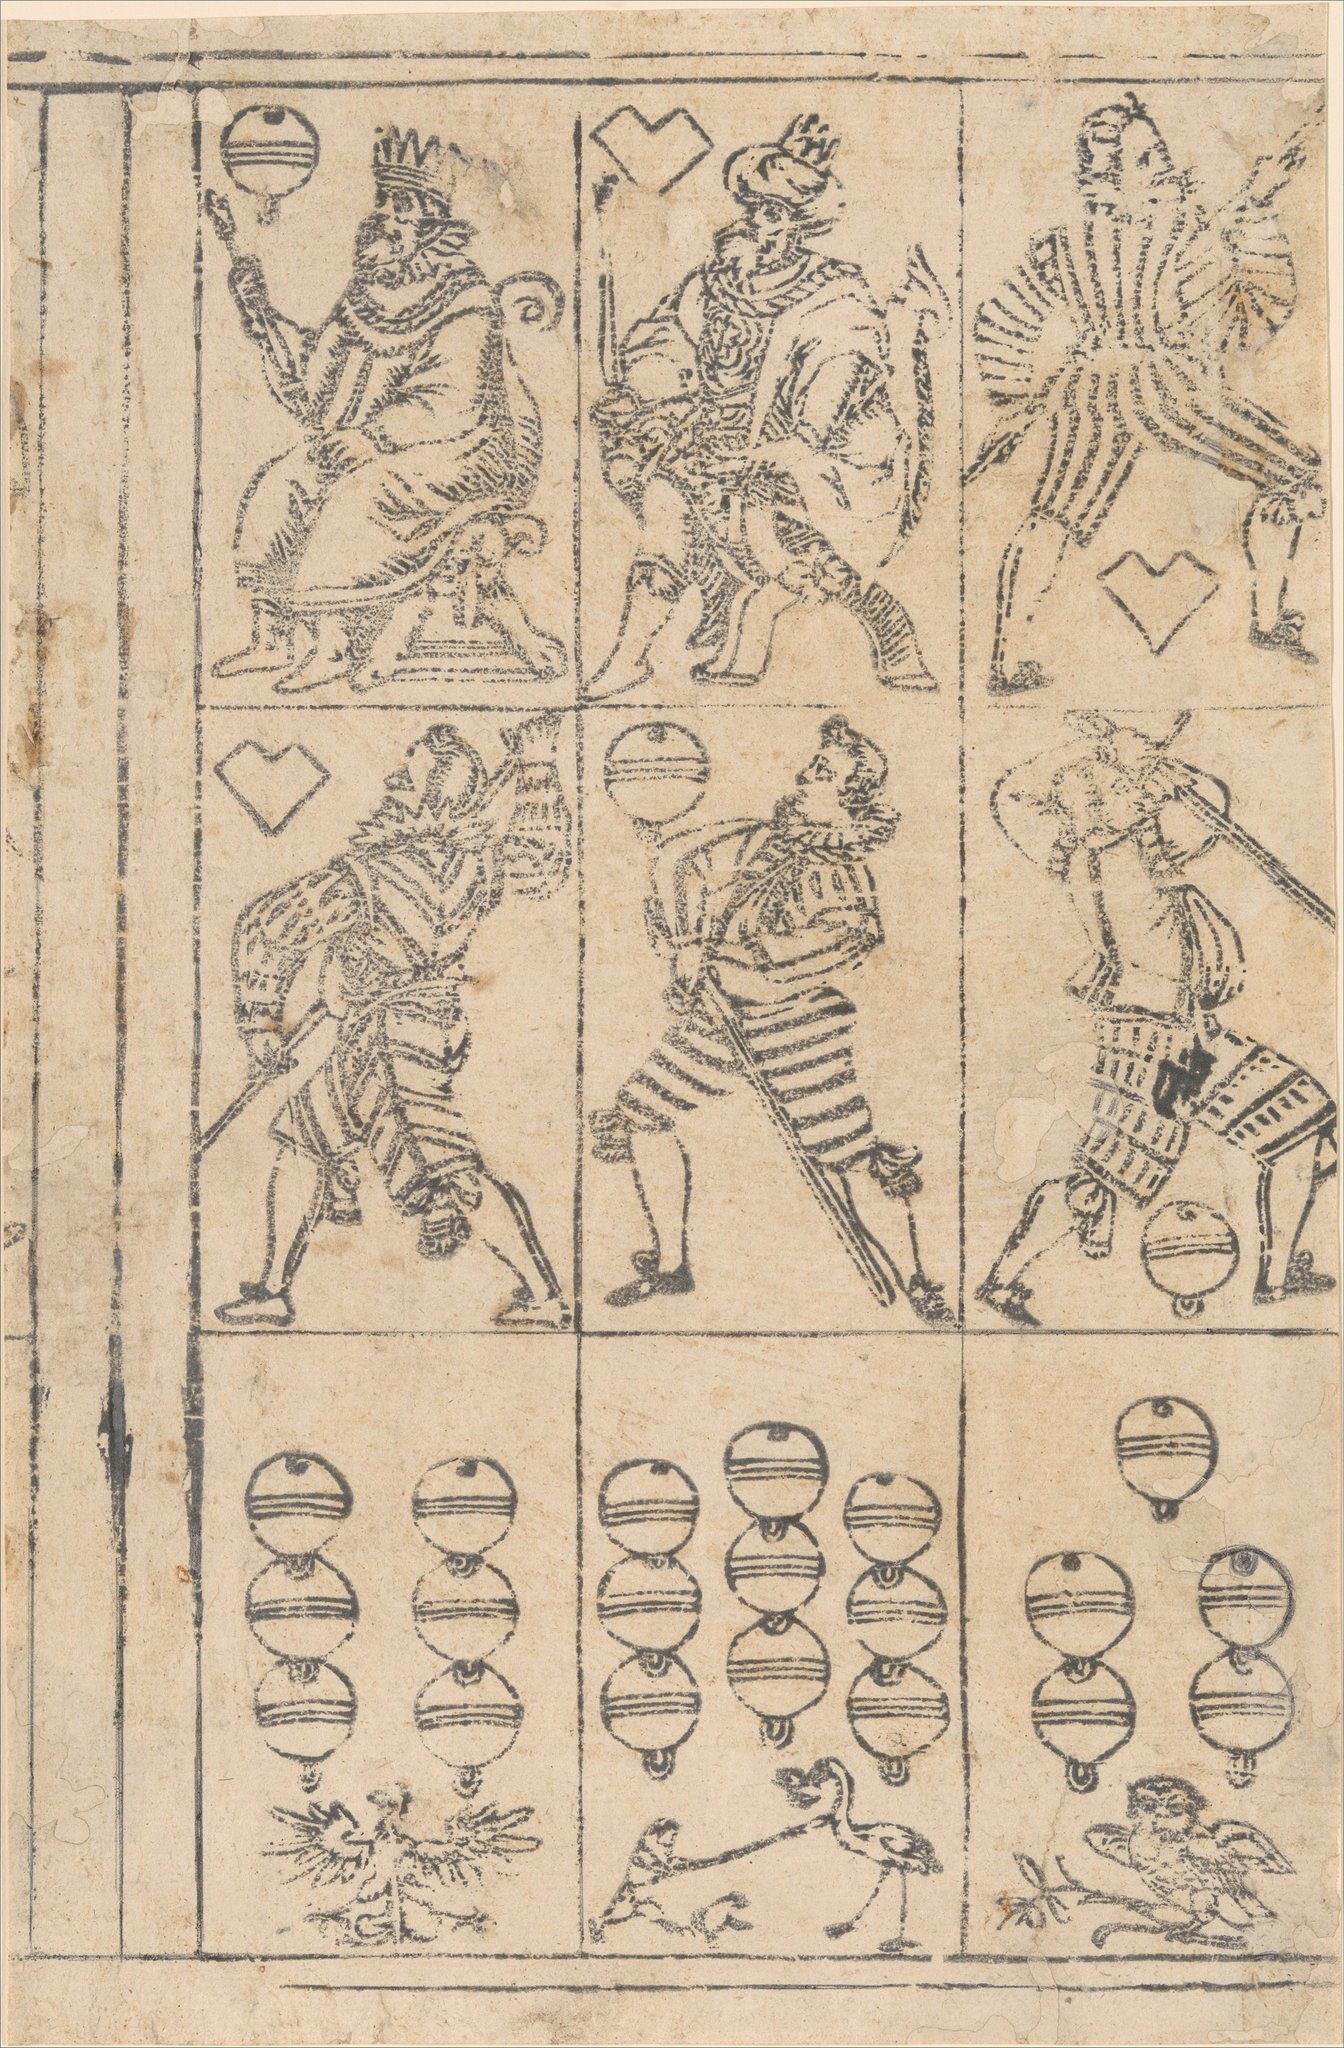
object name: print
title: Sheet of Playing Cards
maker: georg schachomair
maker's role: artist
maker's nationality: german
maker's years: 1501-1600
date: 1501-1600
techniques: woodcut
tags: birds,swords,men